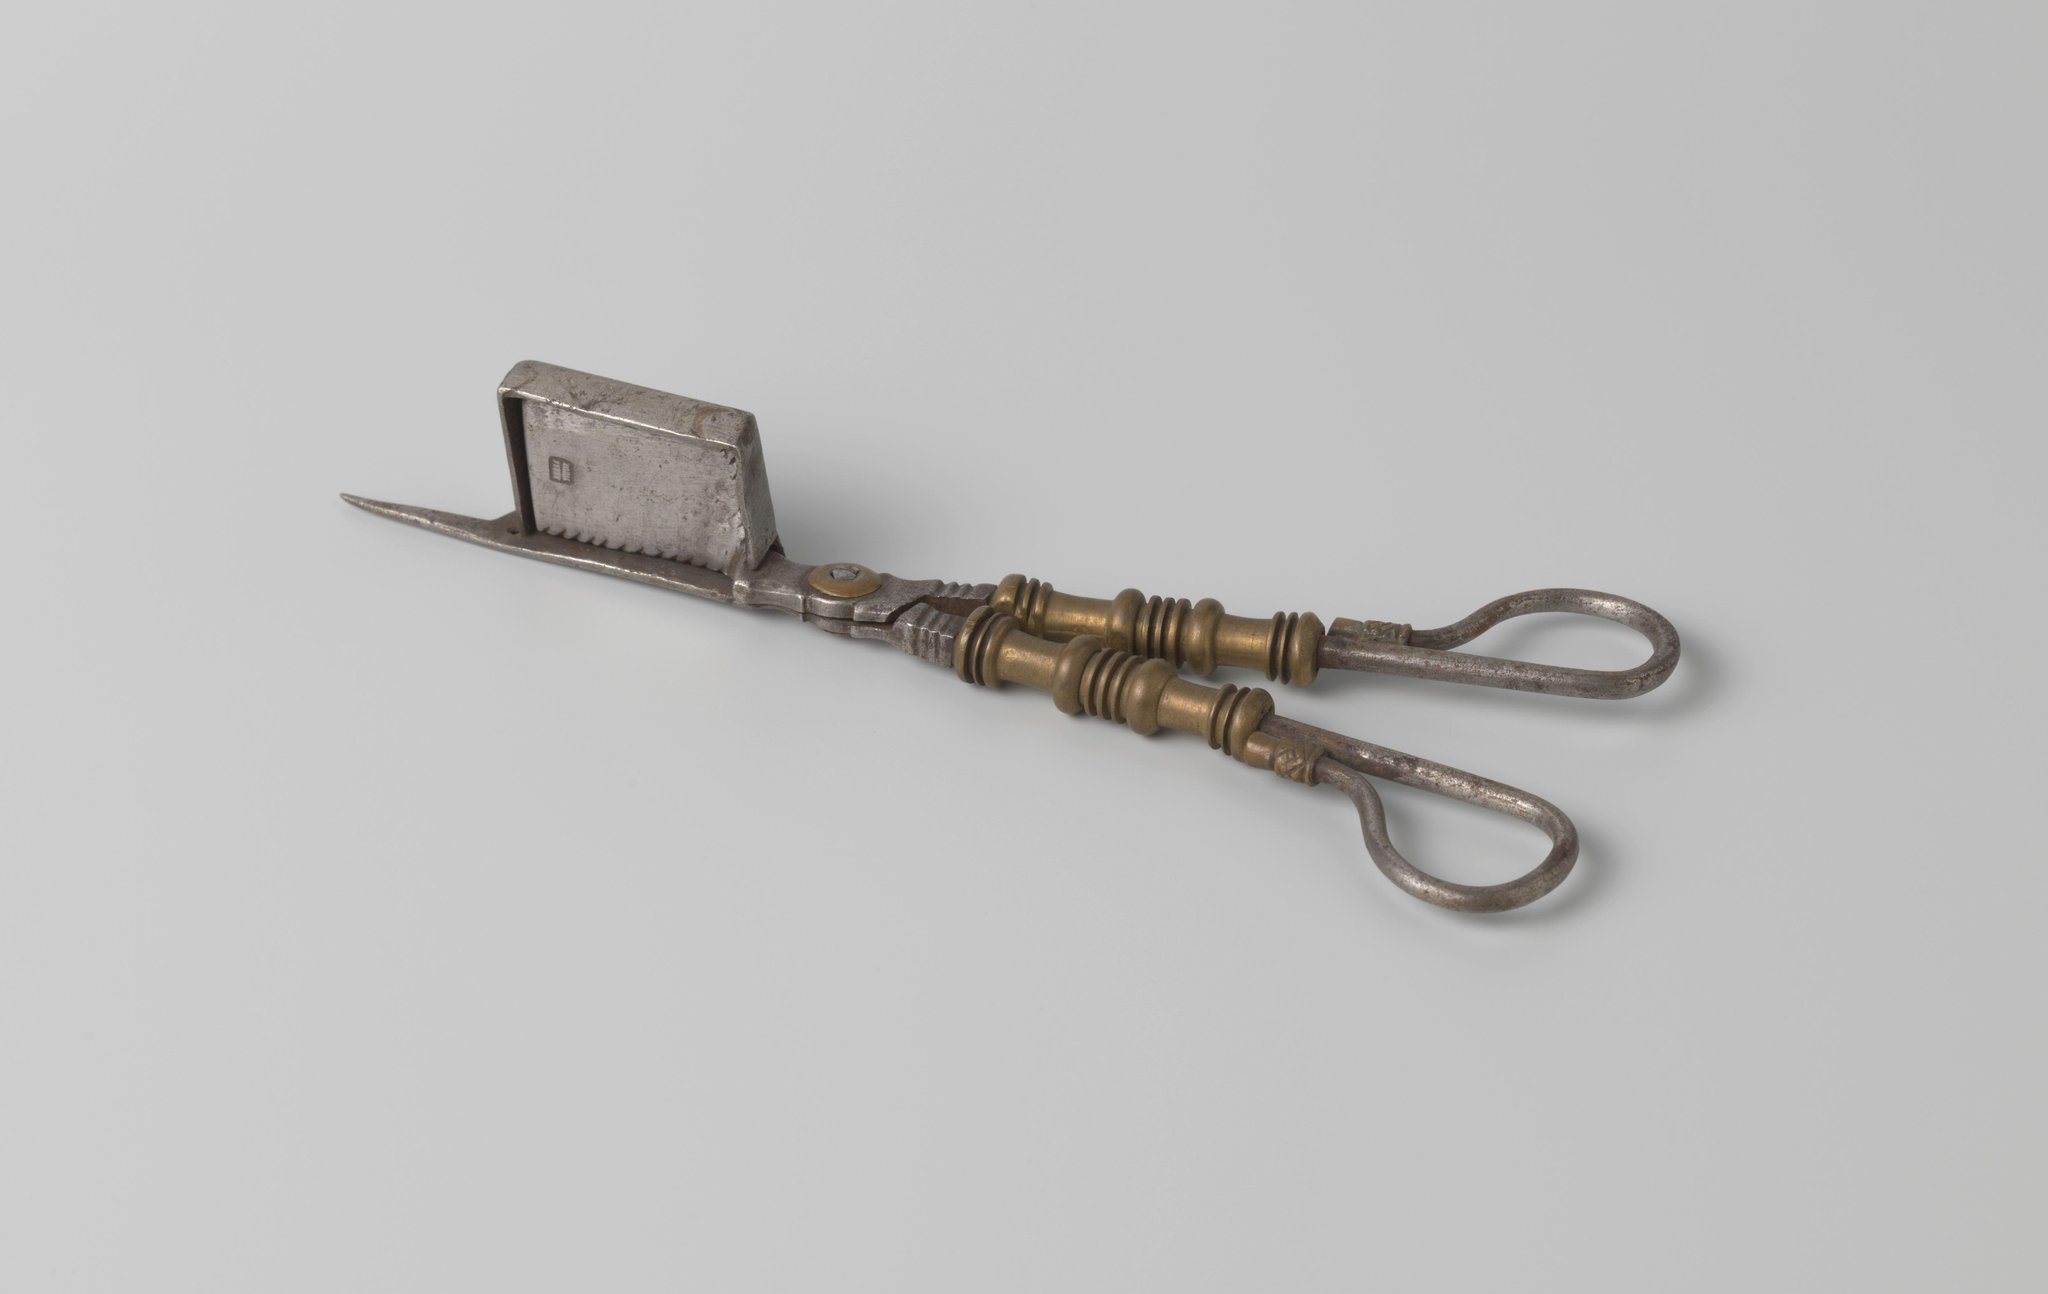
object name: snuiter, snuiterschaar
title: Een ijzeren met koper gemonteerde snuiter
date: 1600-1625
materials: copper, iron